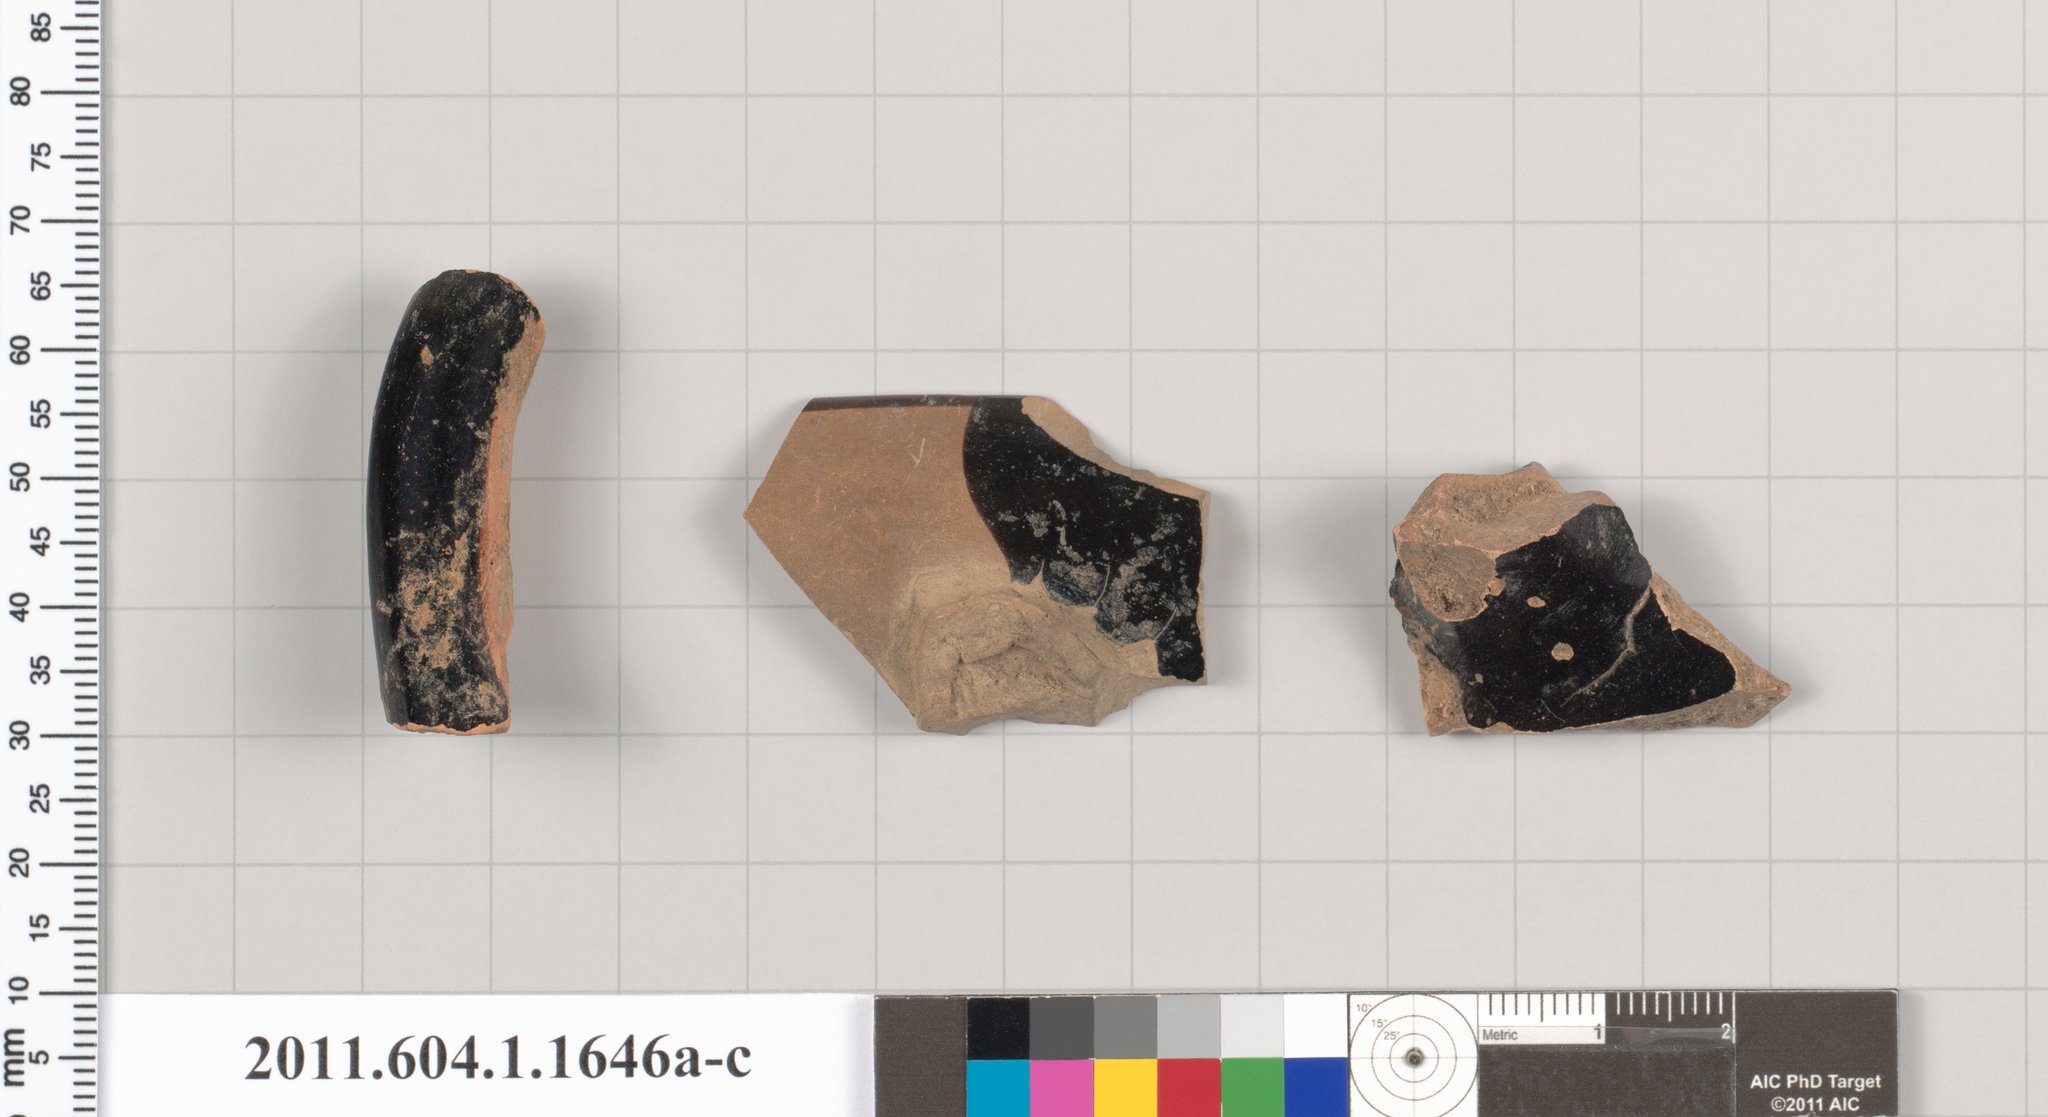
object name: kylix fragment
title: Terracotta fragments of kylikes (drinking cups)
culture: greek, attic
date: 500-401 BCE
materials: terracotta